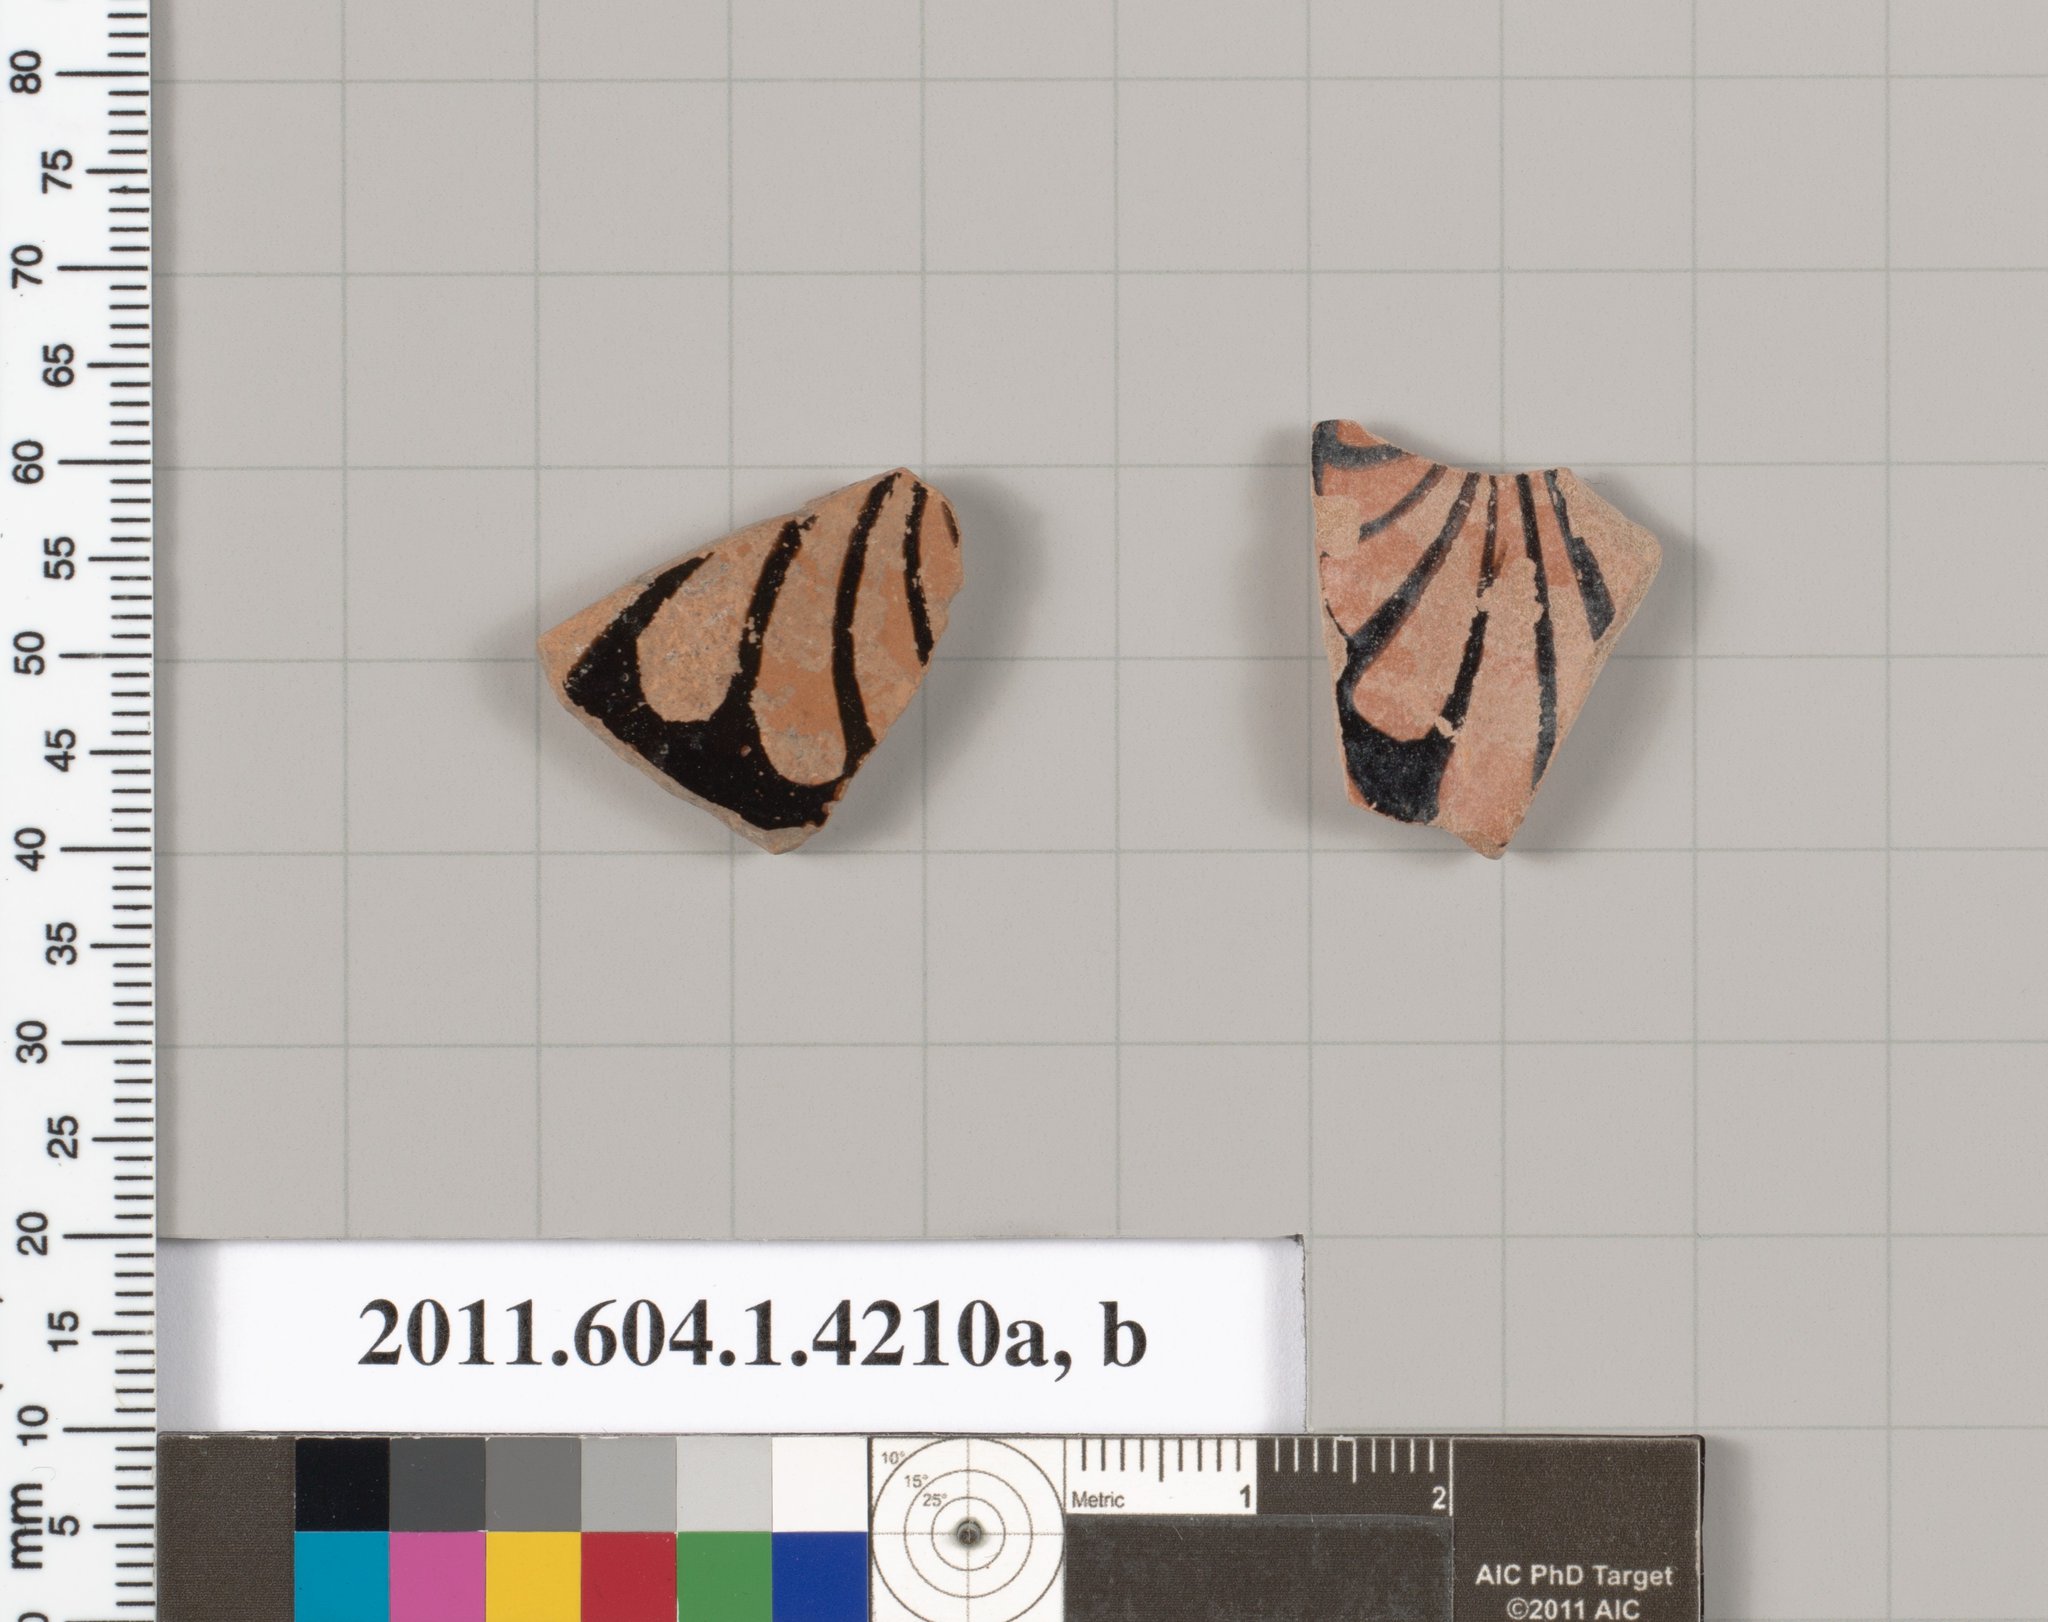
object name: kylix fragment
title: Terracotta fragments of kylikes (drinking cups)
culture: greek, attic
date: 500-451 BCE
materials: terracotta